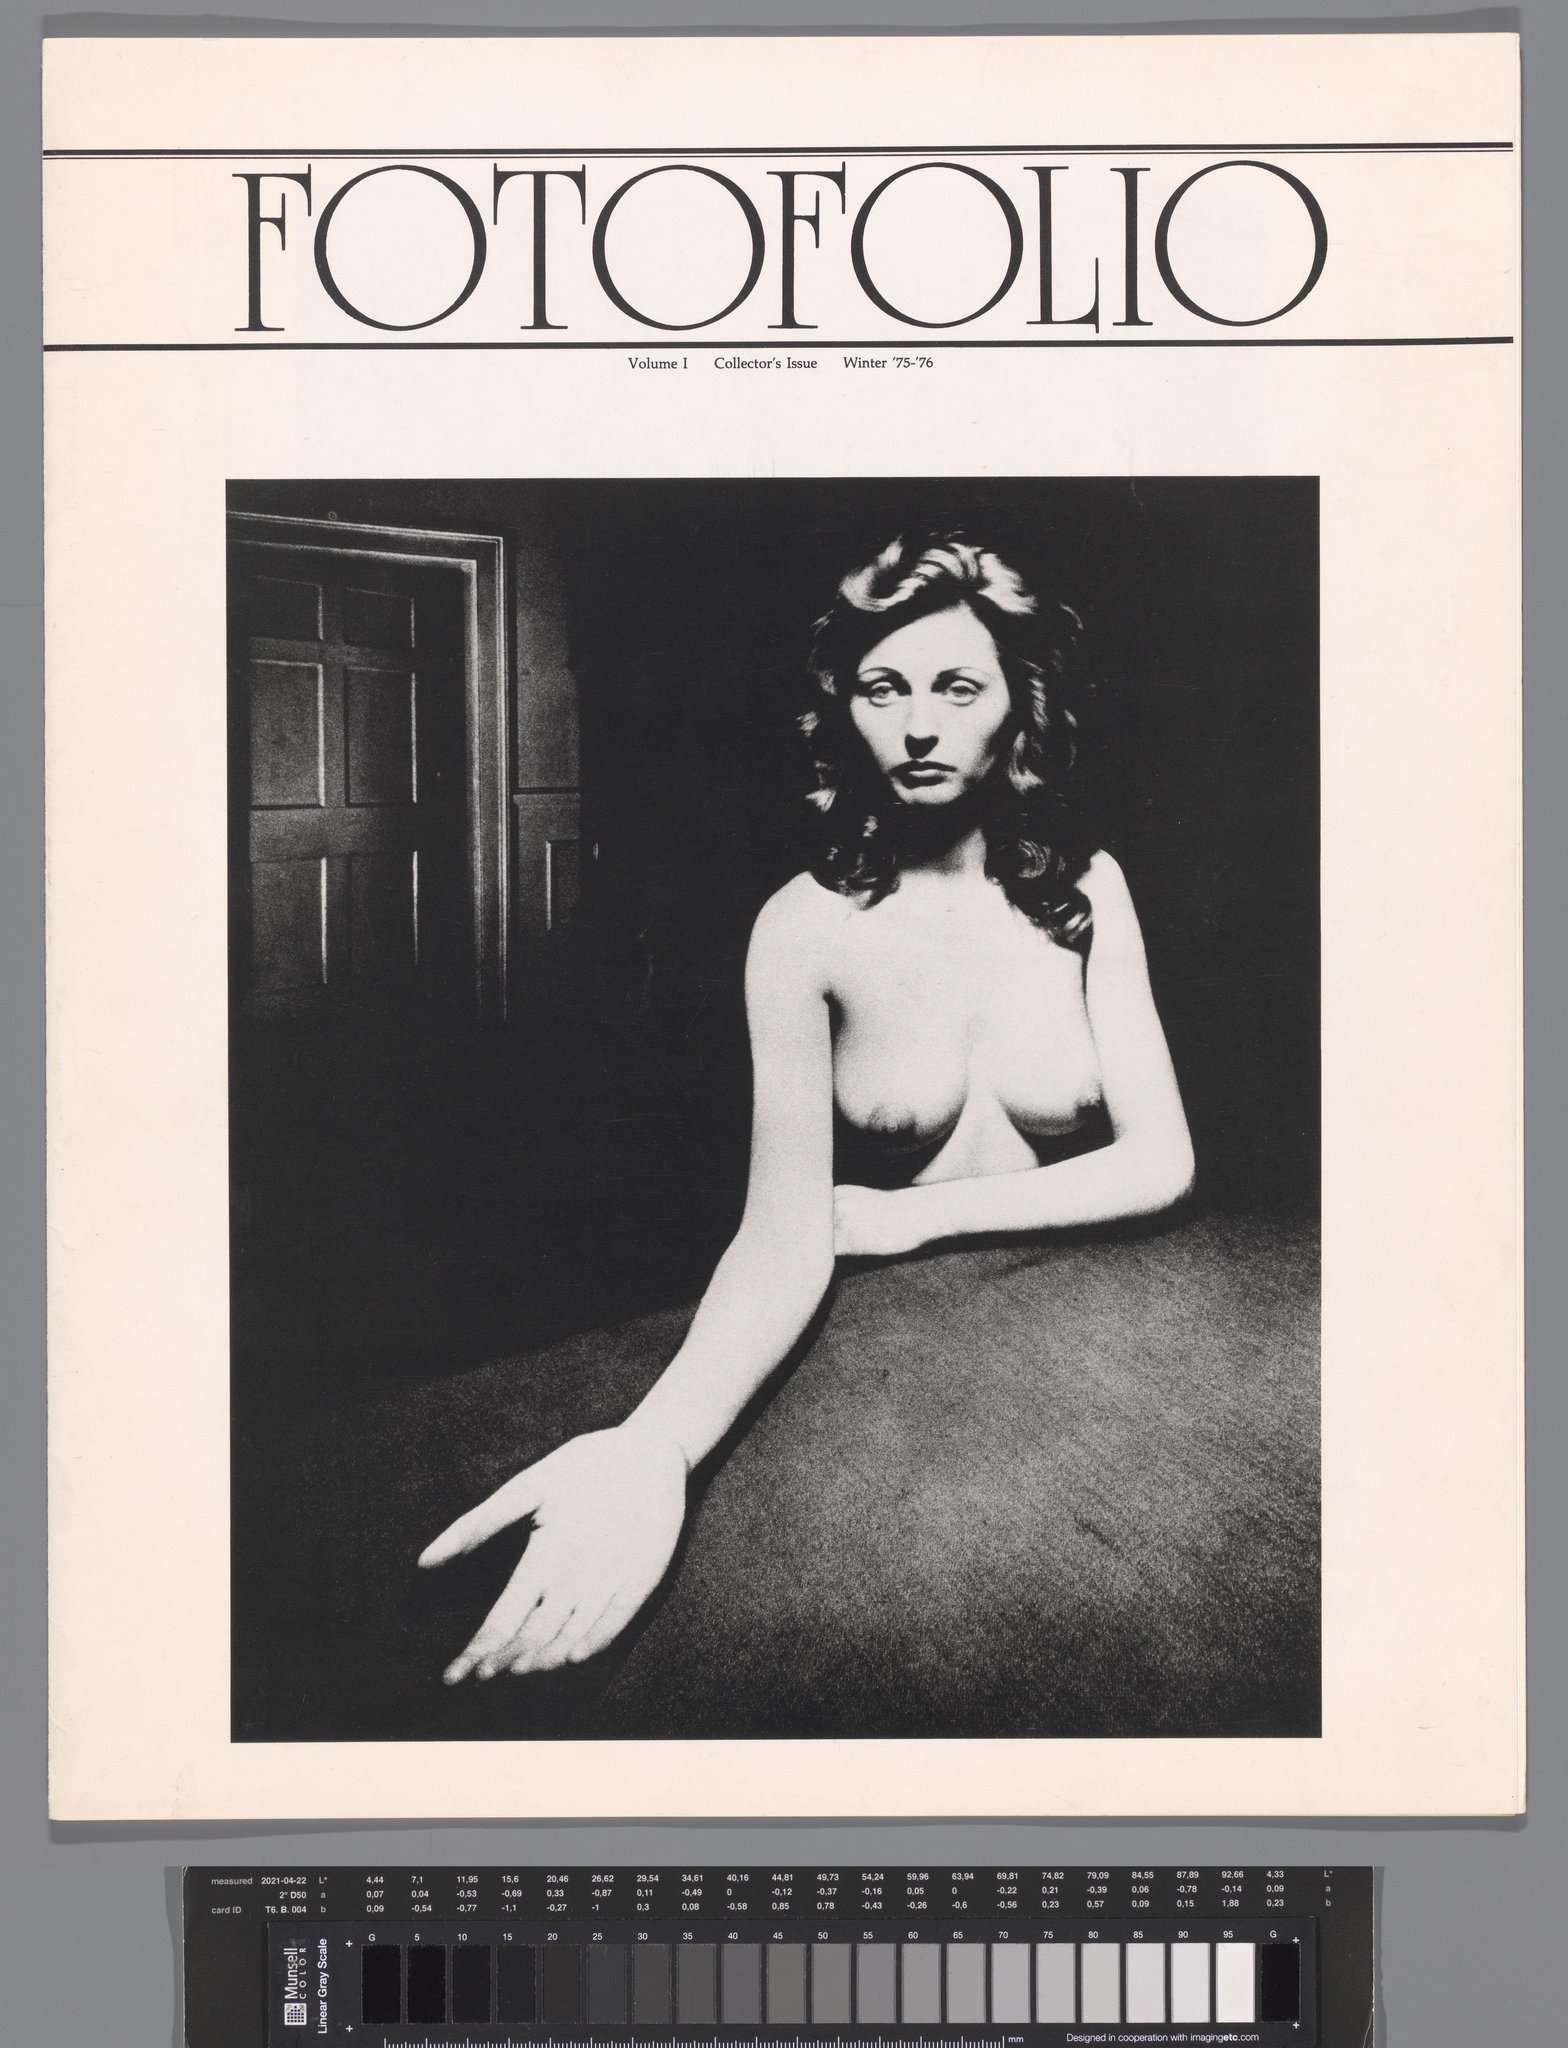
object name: portfolio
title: Fotofolio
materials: paper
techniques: offset printed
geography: new york city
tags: city-view in general; 'veduta', the (nude) human figure; 'corpo humano' (ripa), historical persons - bb - woman, nun(s), historical persons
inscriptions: number: ‘Volume I Collector's Issue Winter '75-'76.’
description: Eerste uitgave van 'Fotofolio' met portfolio van het fotografische werk van diverse fotografen in 10 fotomechanische afdrukken op 3 bladen.